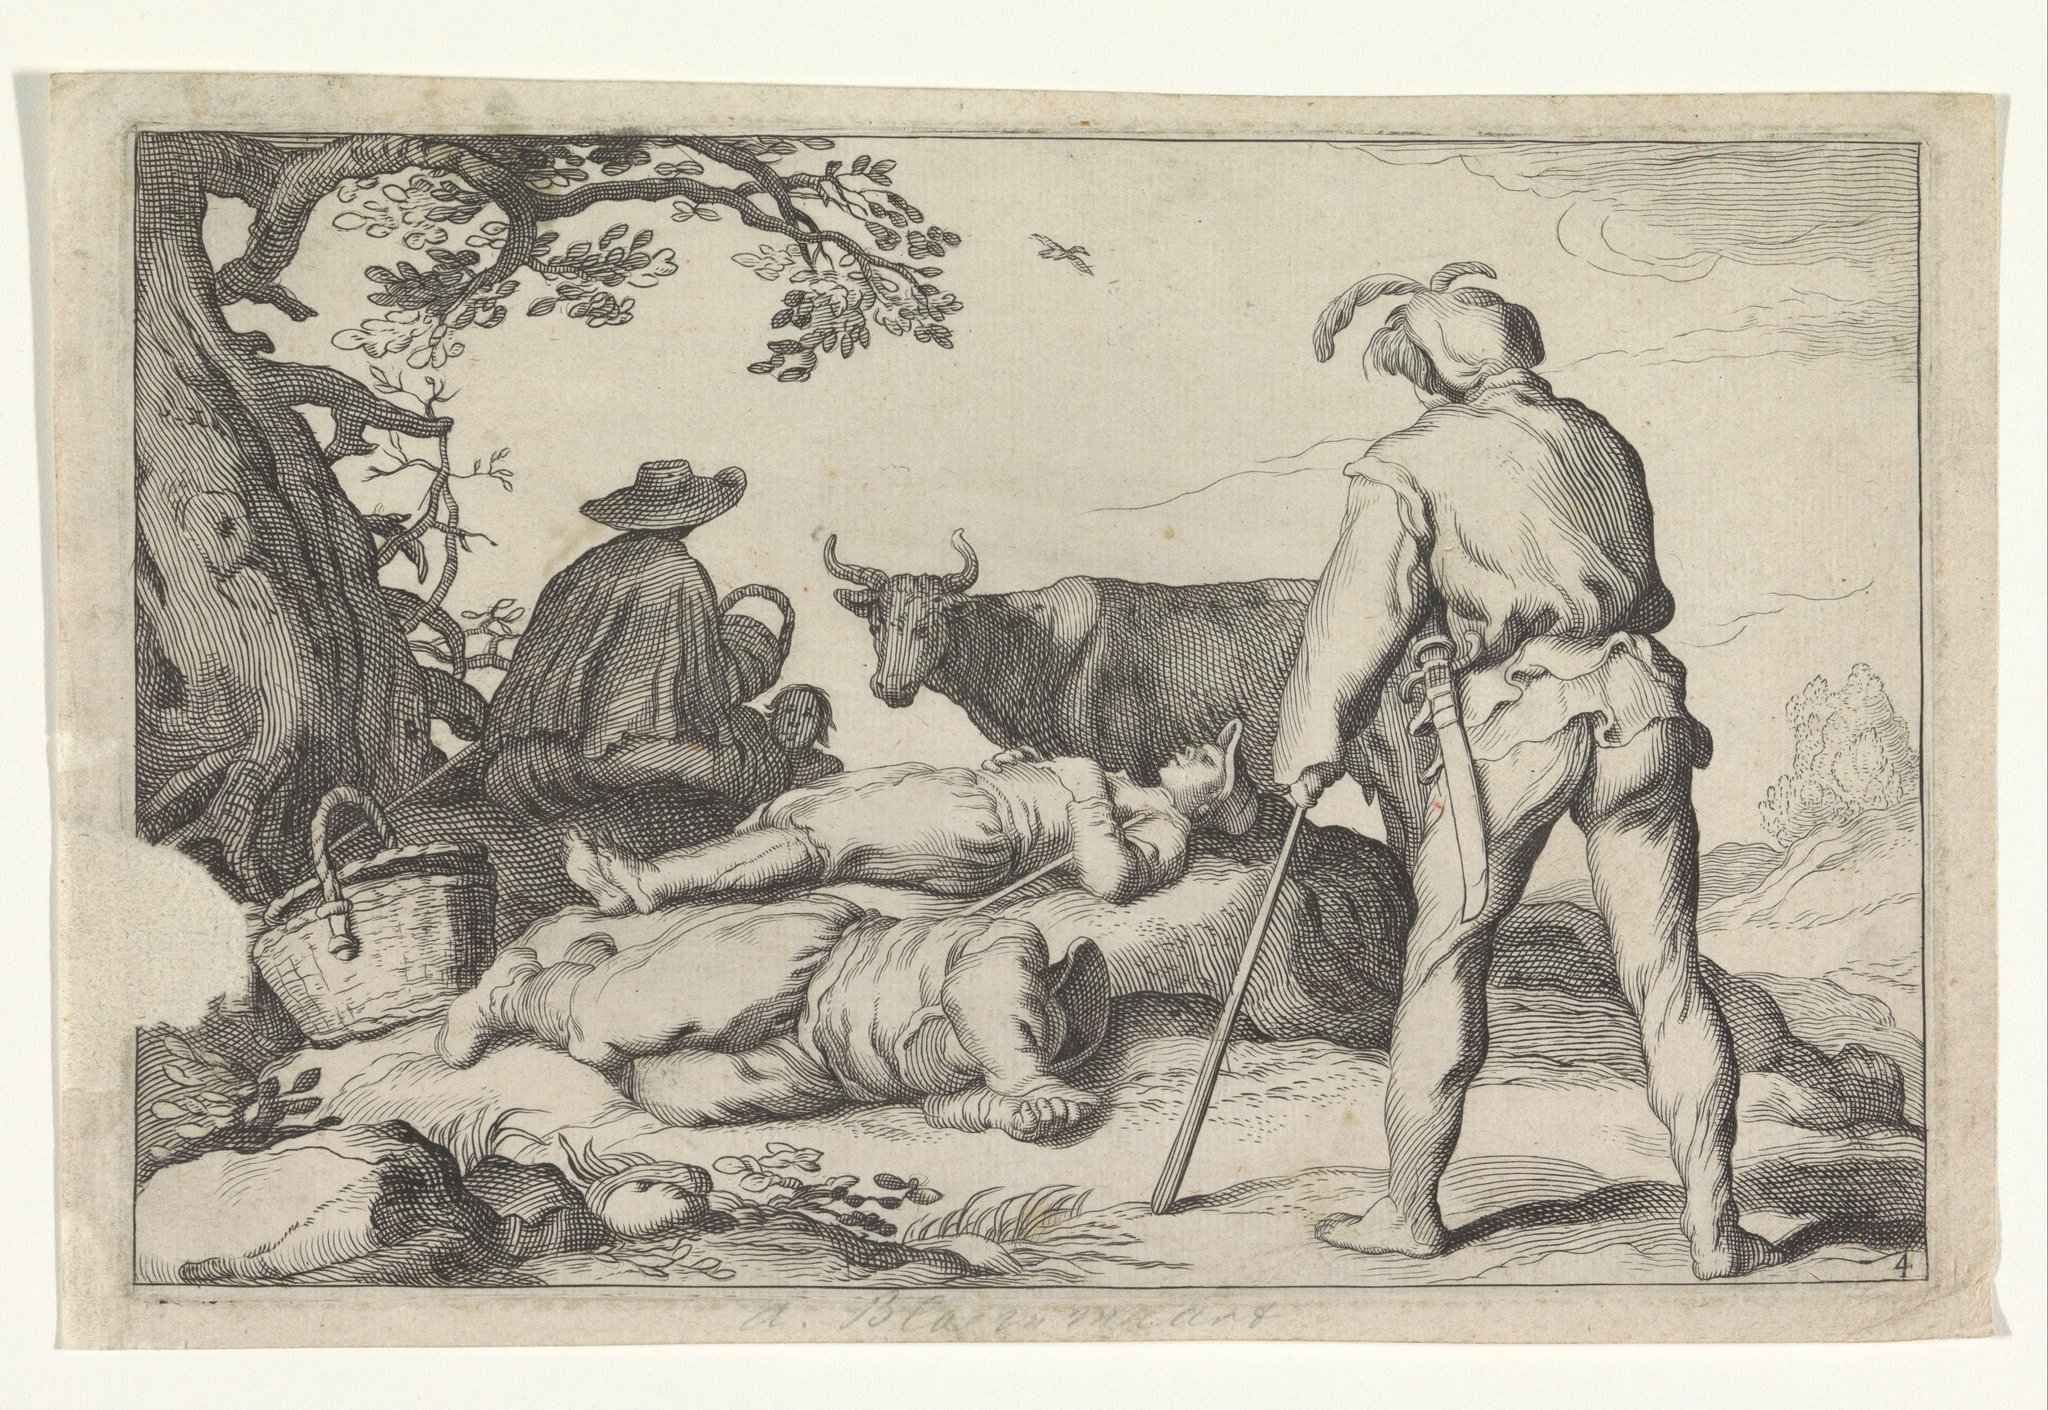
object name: print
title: Otia delectant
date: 1638-1652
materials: paper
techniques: engraving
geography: amsterdam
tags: herding, herdsman, herdswoman, shepherd, shepherdess, cowherd, etc., pastorals, arcadian scenes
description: Vijf veehoeders zitten of liggen onder een boom in een landelijke omgeving. Naast hen staat een stier. Prent vier uit een serie van vier pastorale scènes.